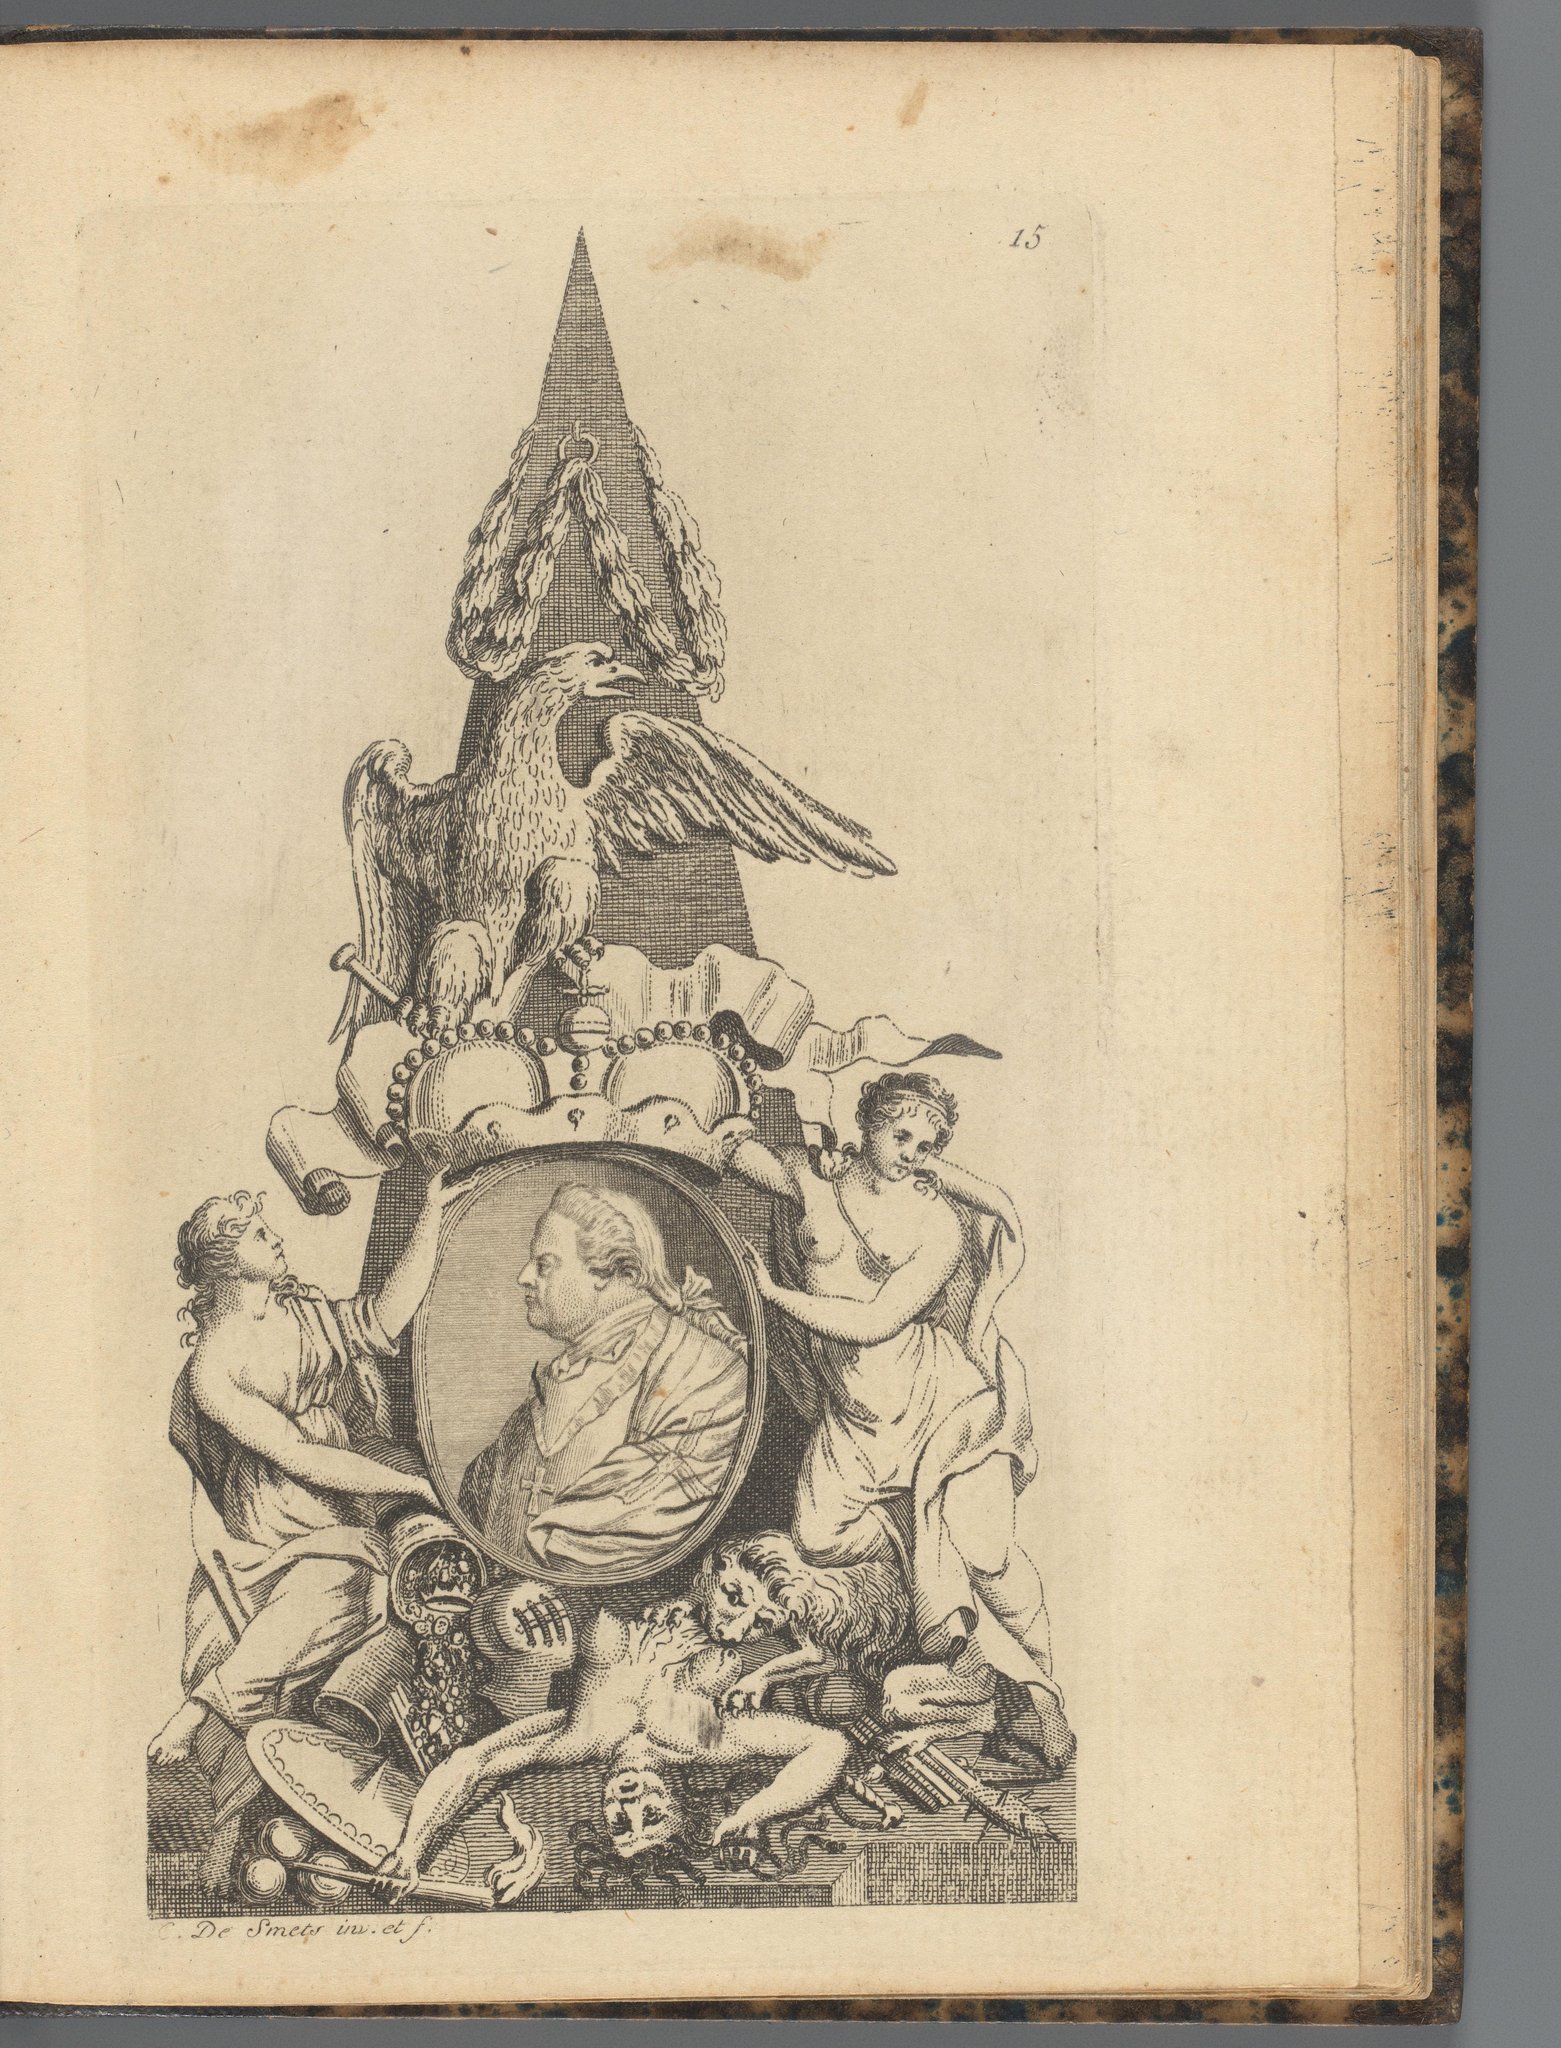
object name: print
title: Piramide met portret van Leopold II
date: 1772-1773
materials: paper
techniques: engraving, etching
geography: southern netherlands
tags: vienna, leopold ii (keizer van oostenrijk), piece of sculpture, reproduction of a piece of sculpture (+ clay, sand, etc. ~ arts), antwerp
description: Sculptuur in de vorm van een piramide met een medaillon met het portret van keizer Leopold II. Beeld gemaakt door Corneille de Smet, samen met Peeters, Michel Vervoort en Gomare Dom. Genummerd rechtsboven in de plaat: 15. Onderdeel van de verzameling van figuren en beelden gemaakt van sneeuw in de straten van Antwerpen in januari 1772.